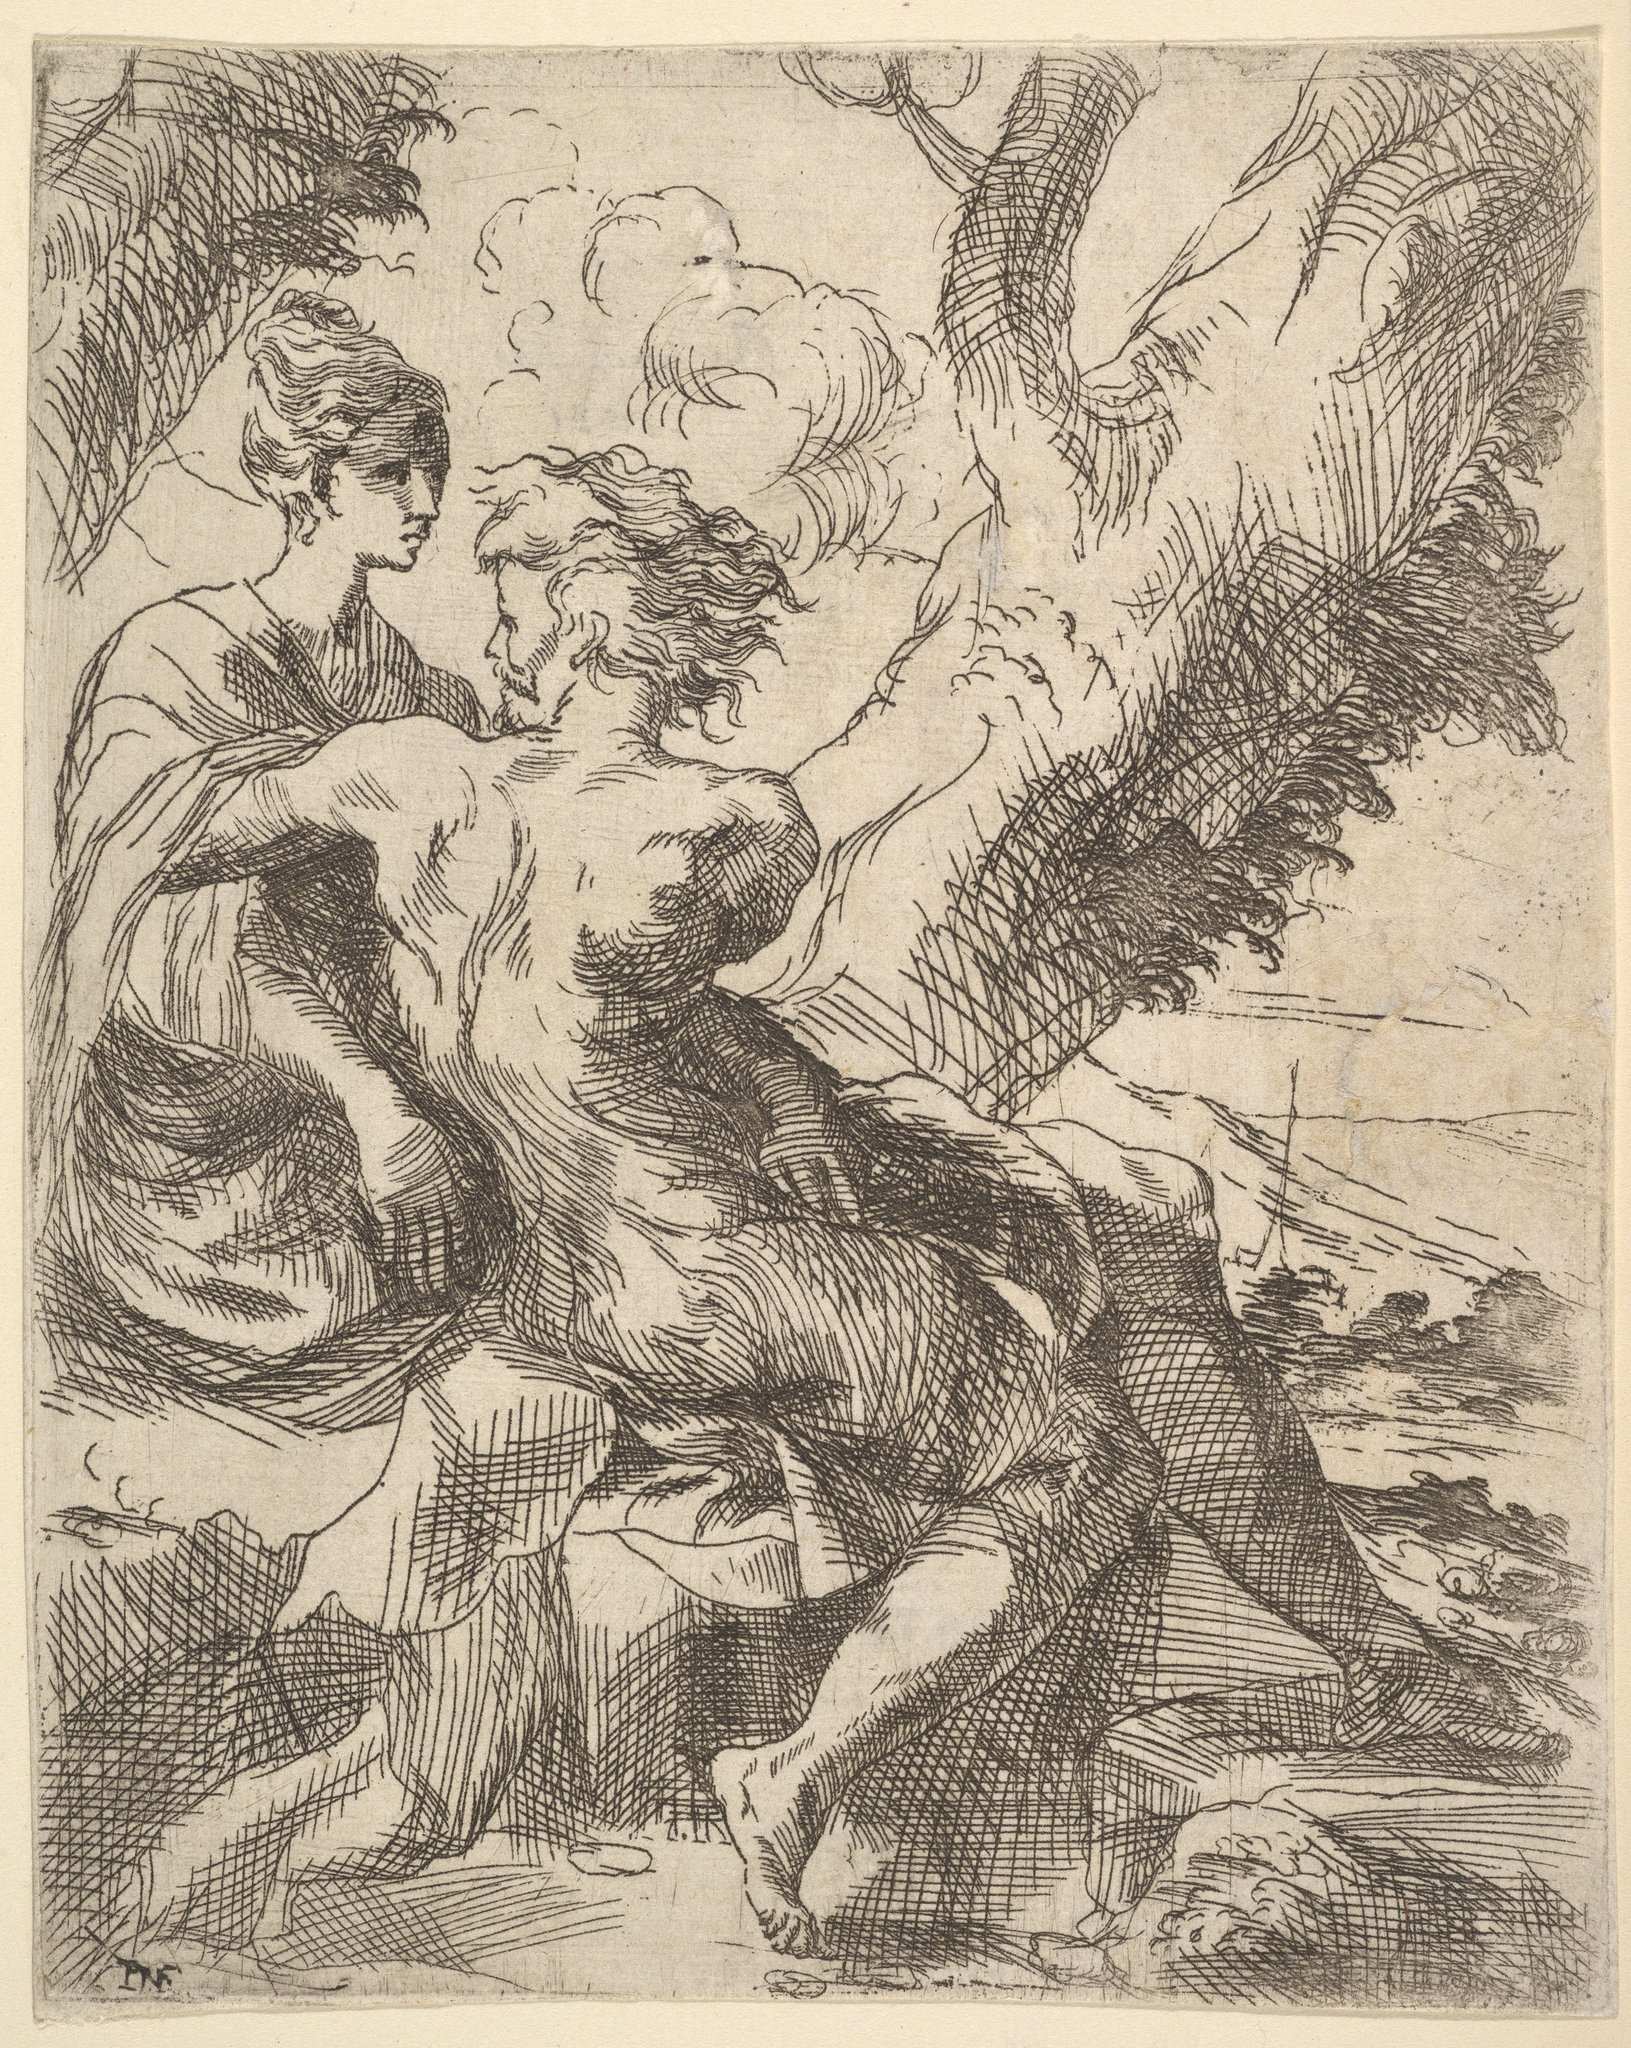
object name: print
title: The Lovers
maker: anonymous, italian, 16th century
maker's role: artist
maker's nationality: italian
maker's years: 1500-1600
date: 1501-1600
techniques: etching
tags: couples,men,lovers,women